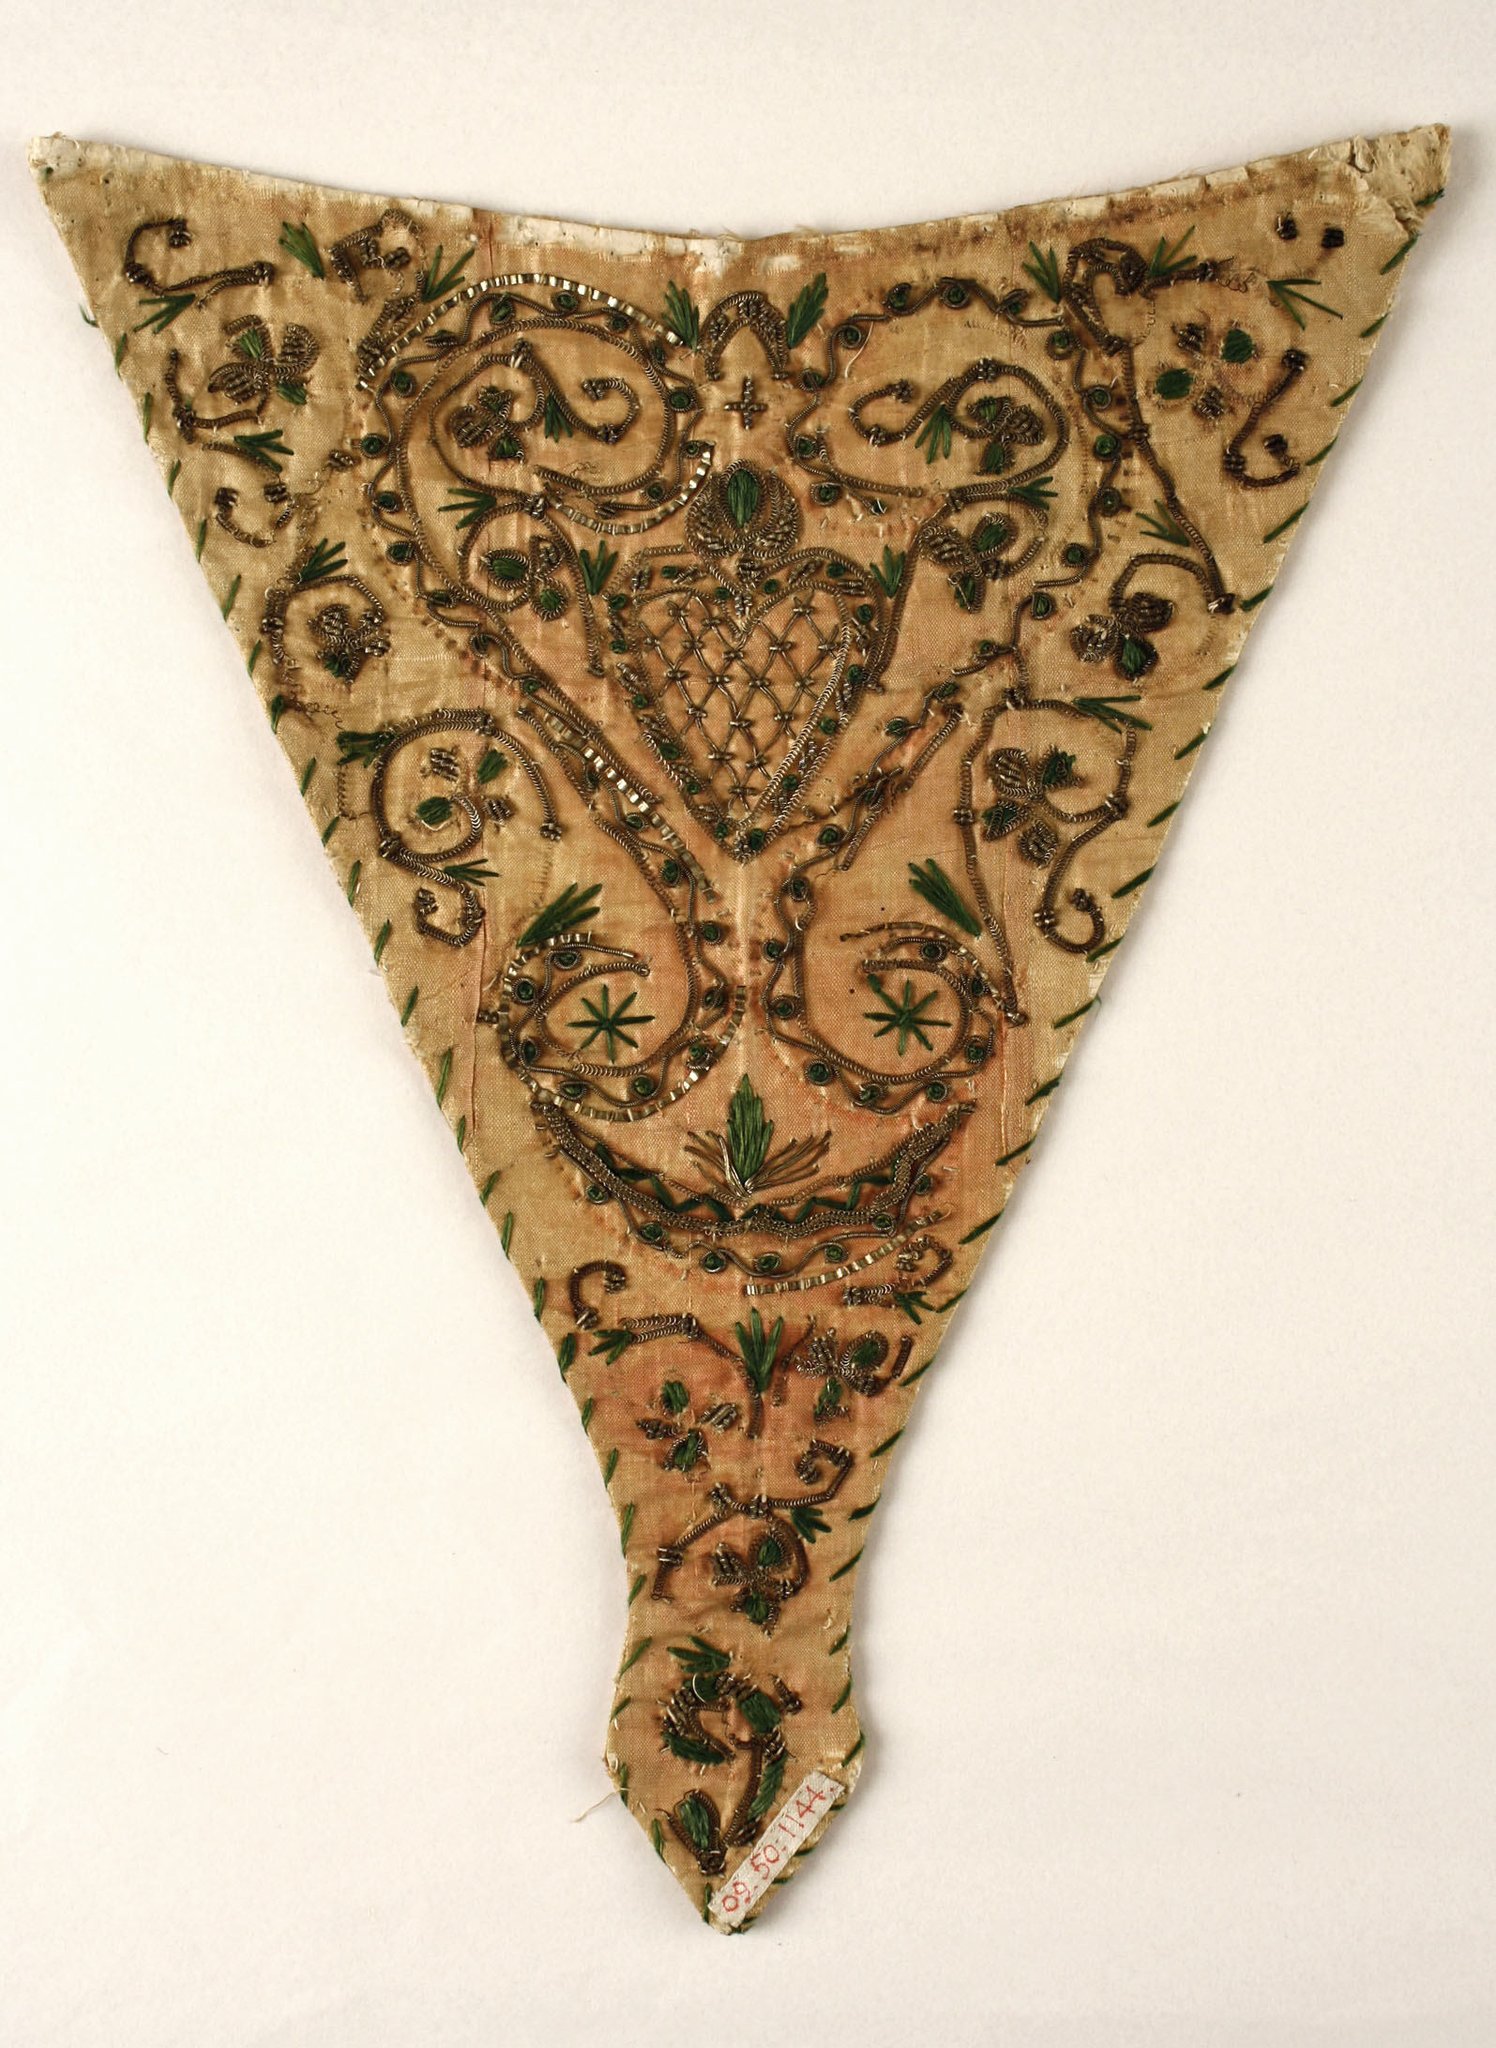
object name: stomacher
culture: german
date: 1767-1800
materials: cotton, silk